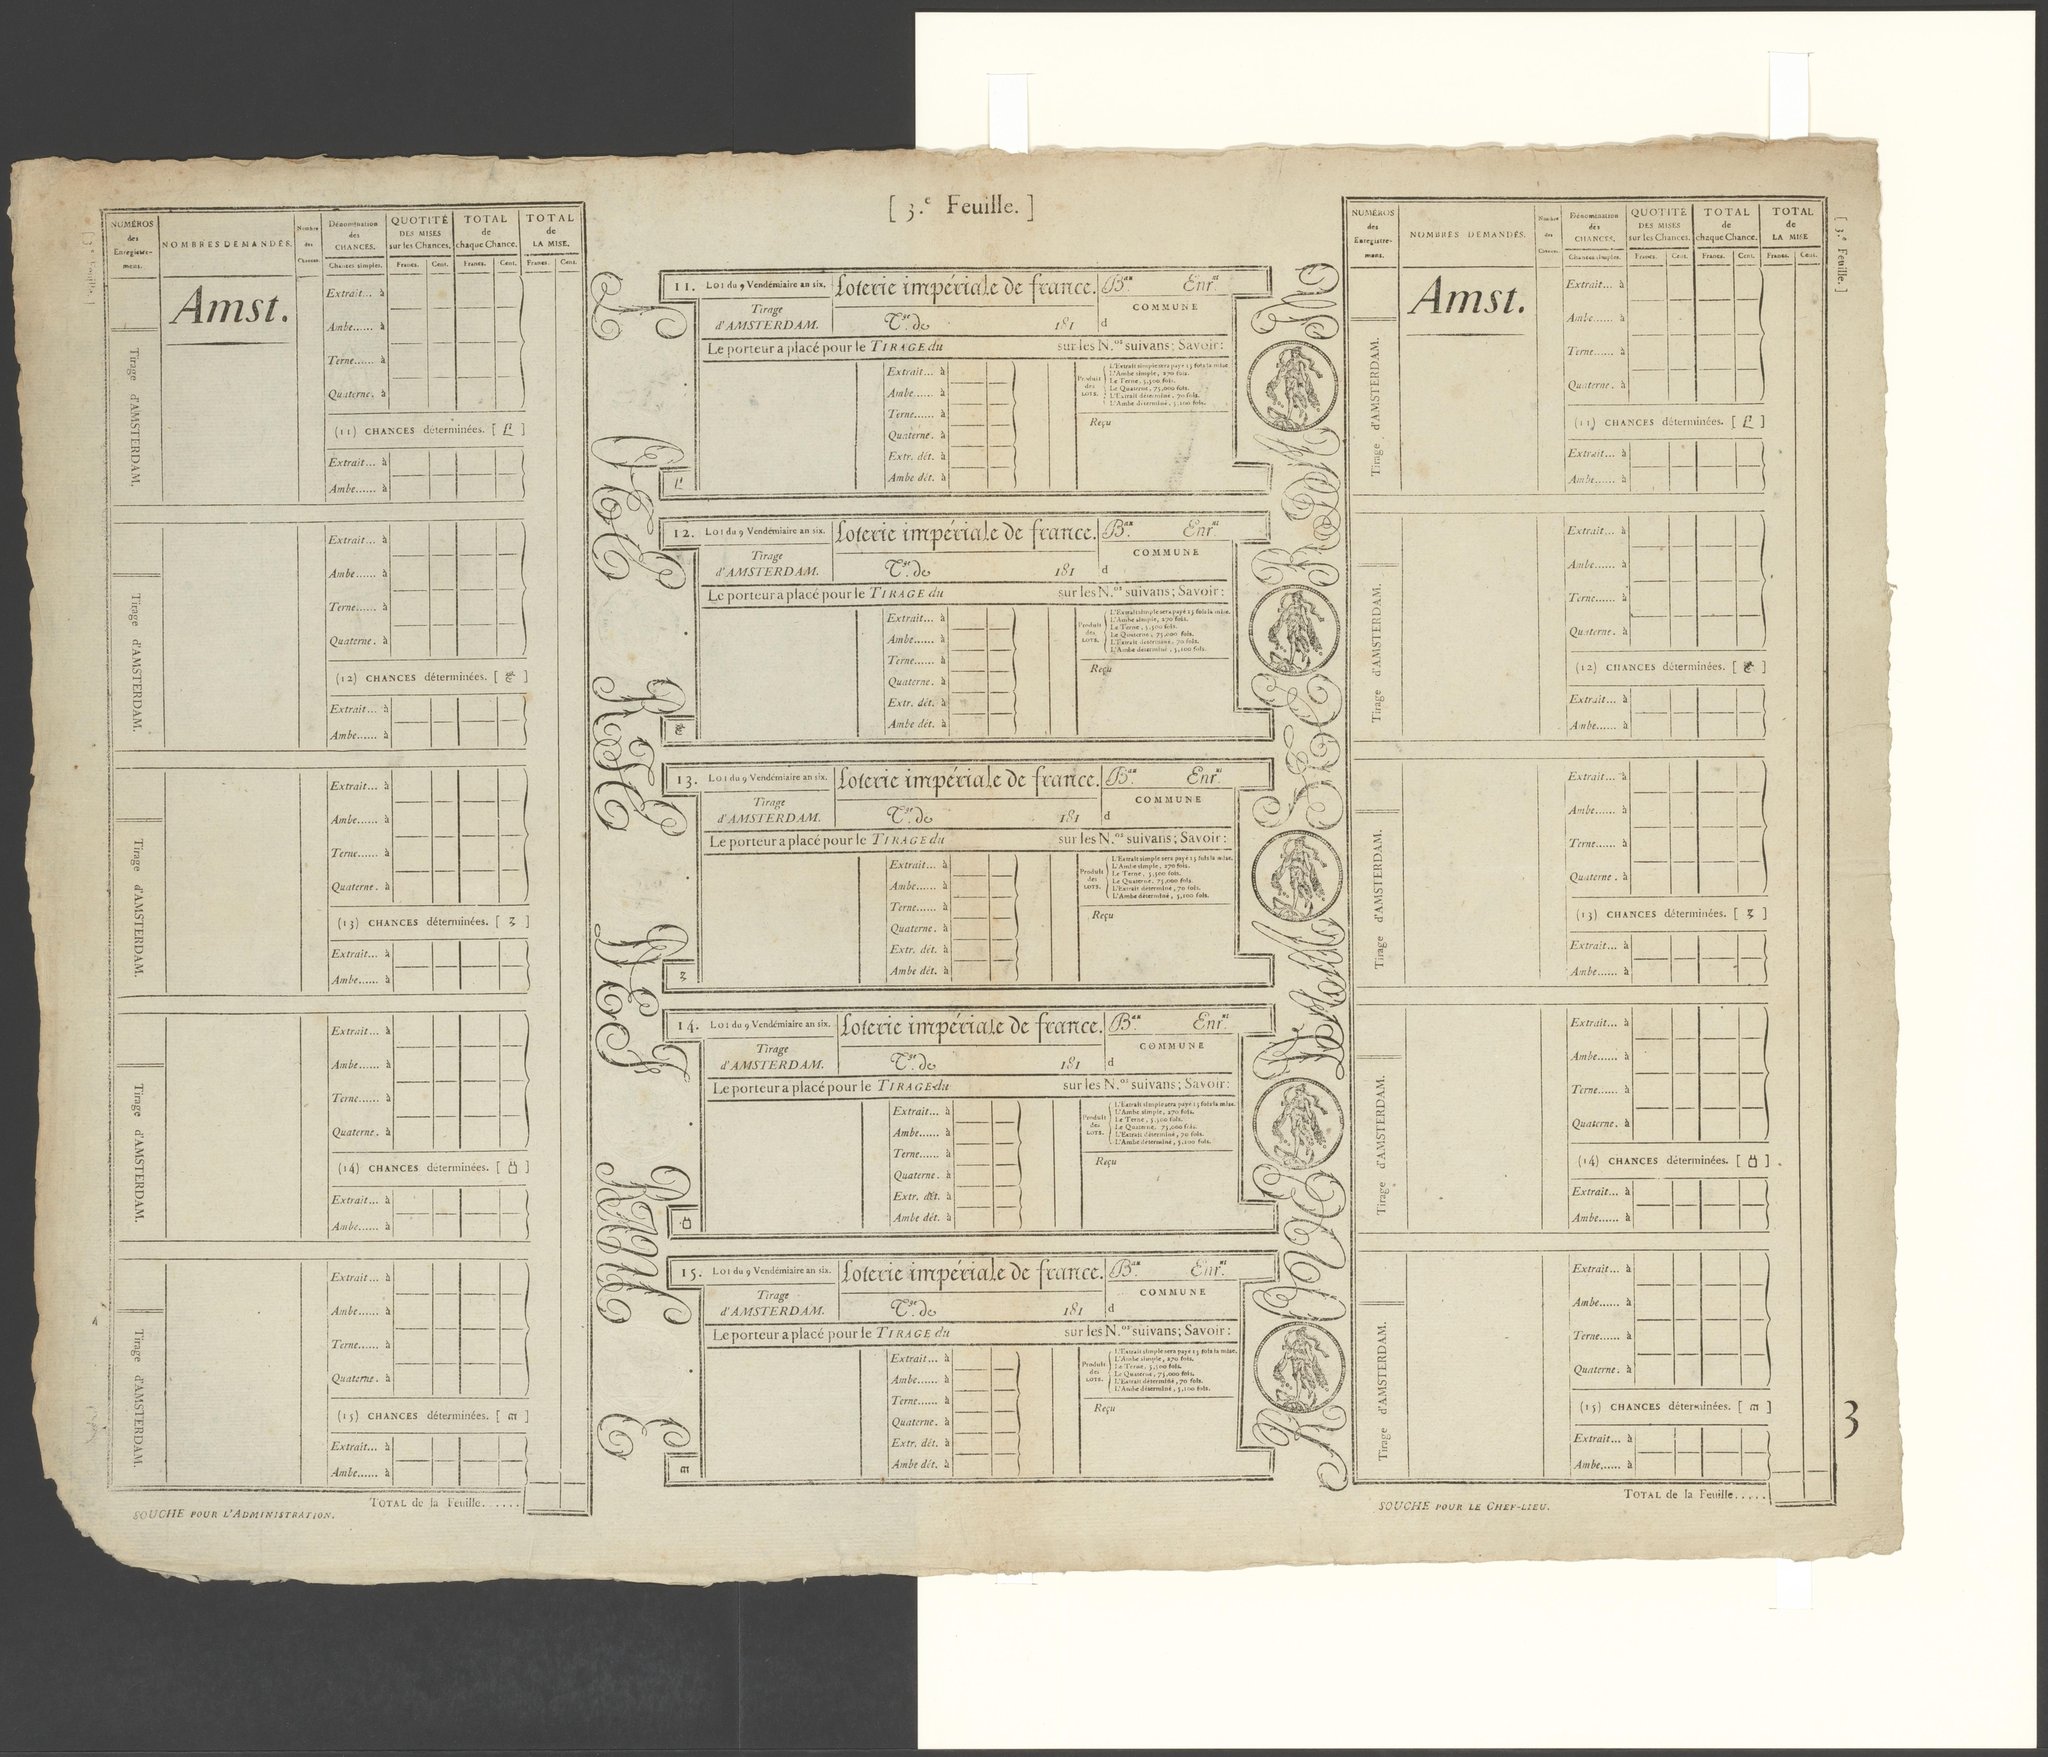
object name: text sheet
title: Onversneden blad met loterijbriefjes van de 'Loterie impériale de france' / 3.re Feuille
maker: Anonymous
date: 1810-1815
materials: paper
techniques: letterpress printing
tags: raffle, lottery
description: Onversneden blad met loterijbriefjes nrs. 11-15 voor de 'Tirage d'Amsterdam' van de van de 'Loterie impériale de france'. Blad genummerd bovenaan '3e Feuille'. Zoals vastgelegd bij de wet in Vendémiaire (jaar 1797-1798), met voorgedrukte trekkingsdatum 181... Onderwerpsrubrieken binnen de Atlas Zeden en Gewoonten: Spel en Vermaak; Loterij.